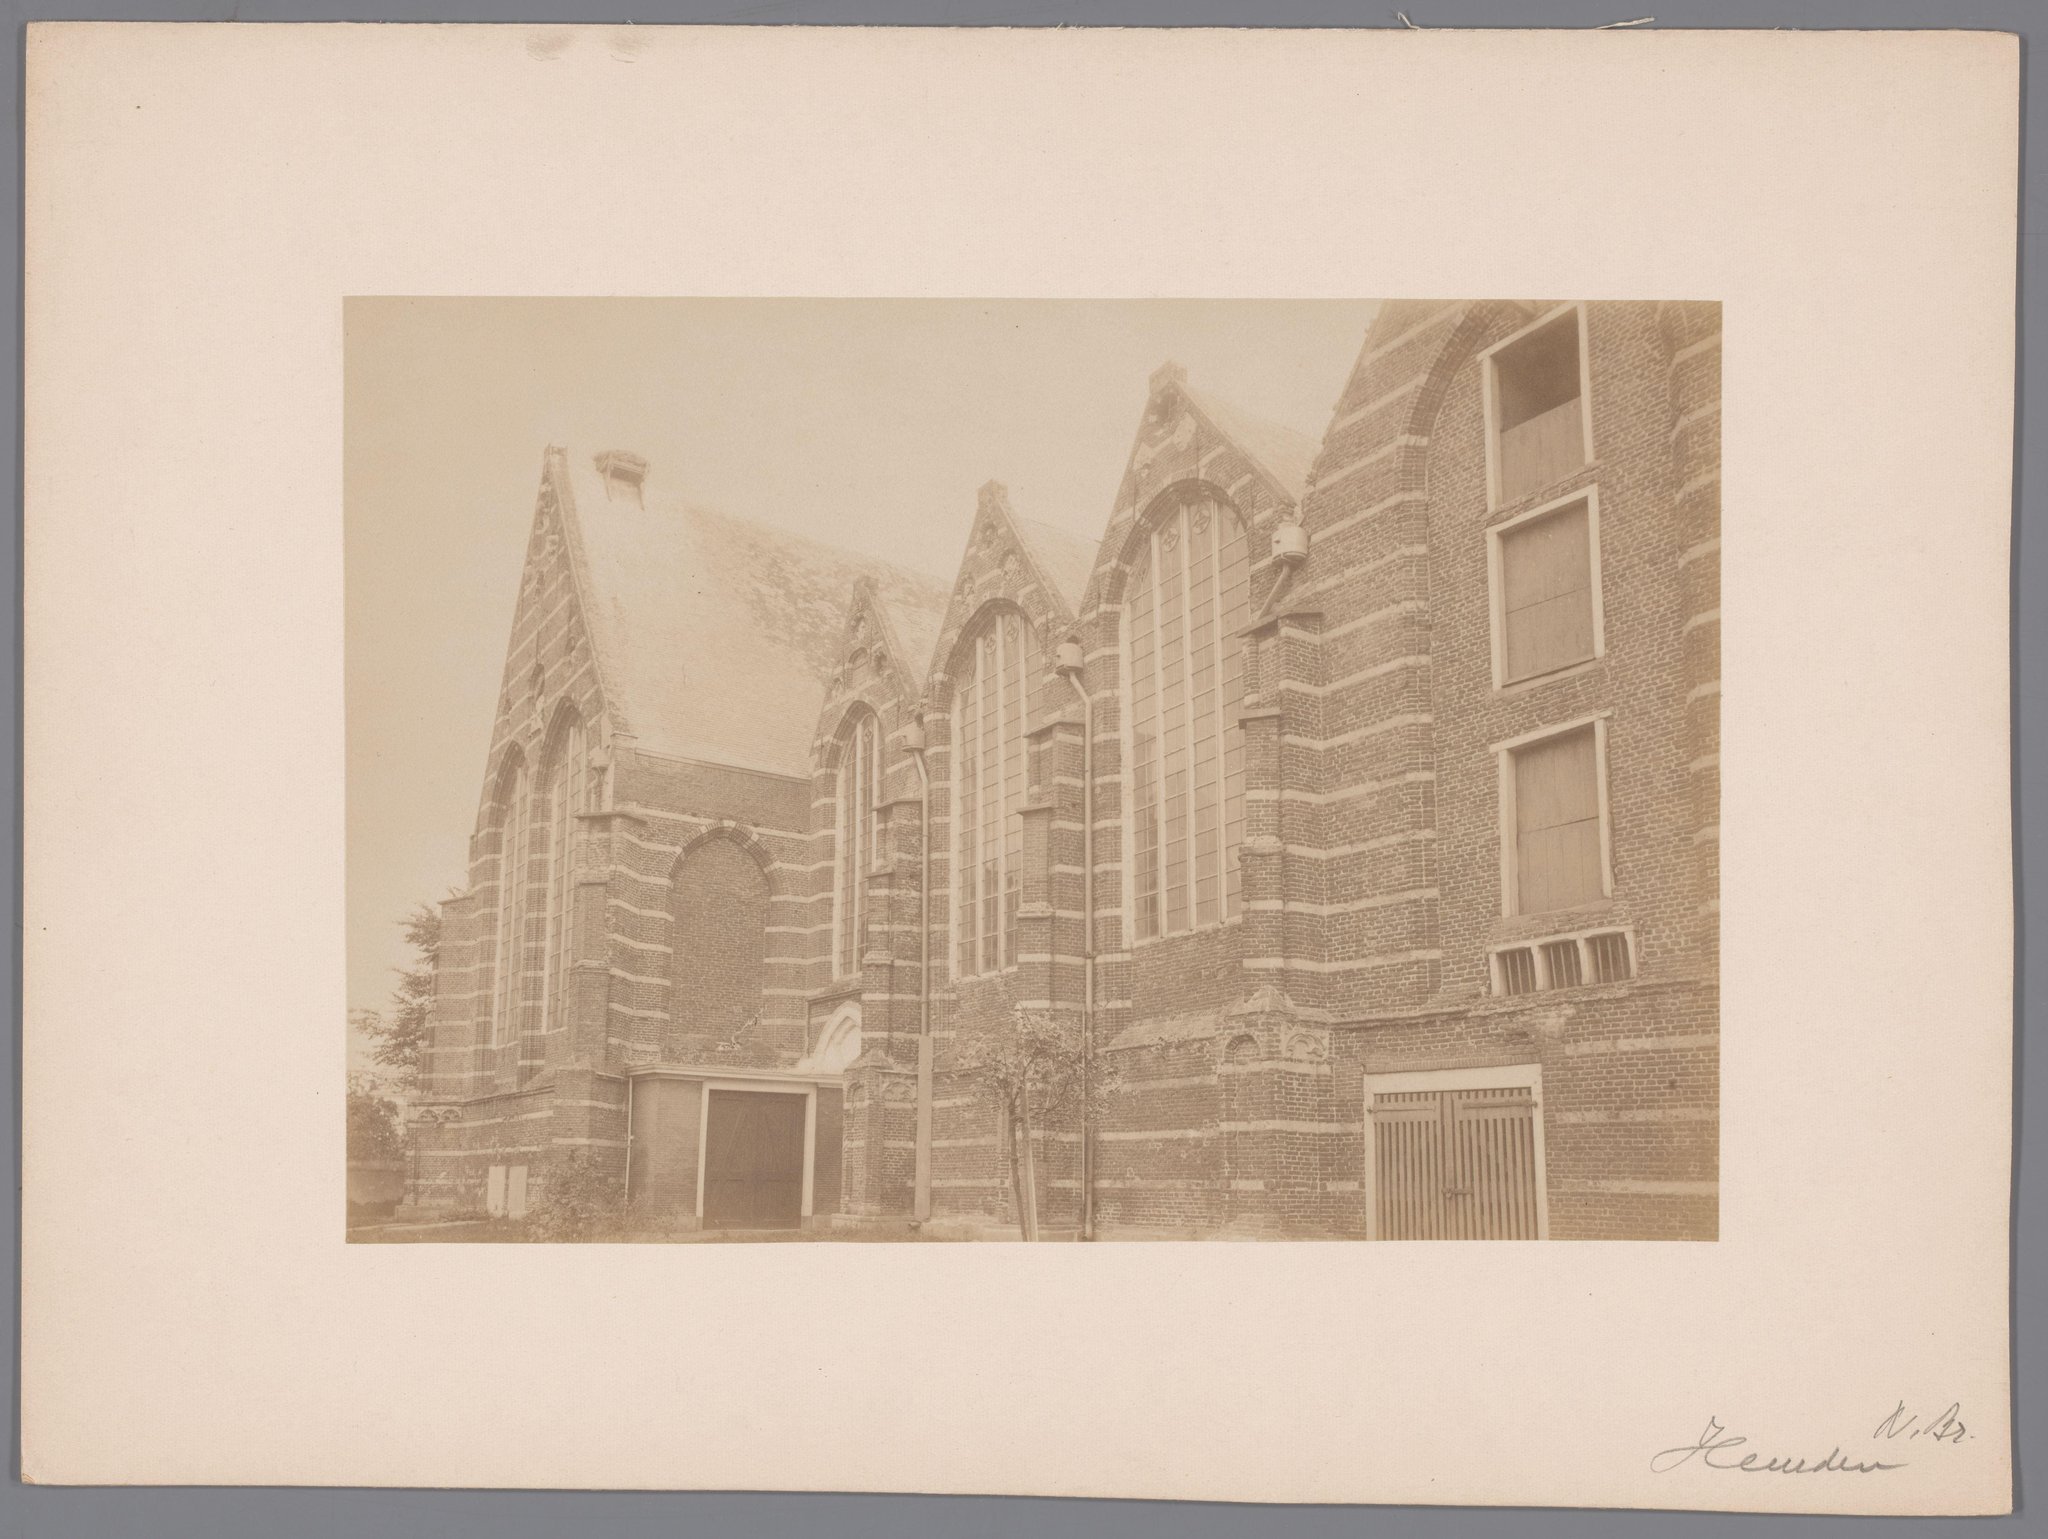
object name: photograph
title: Gedeelte van de Grote of St. Catharinakerk te Heusden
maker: anoniem (monumentenzorg)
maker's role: fotograaf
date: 1904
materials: cardboard, photographic support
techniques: albumen print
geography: heusden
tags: church (exterior)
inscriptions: annotation: ‘Heusden (NB/ oct 1904’, annotation: ‘Heusden N.Br.’